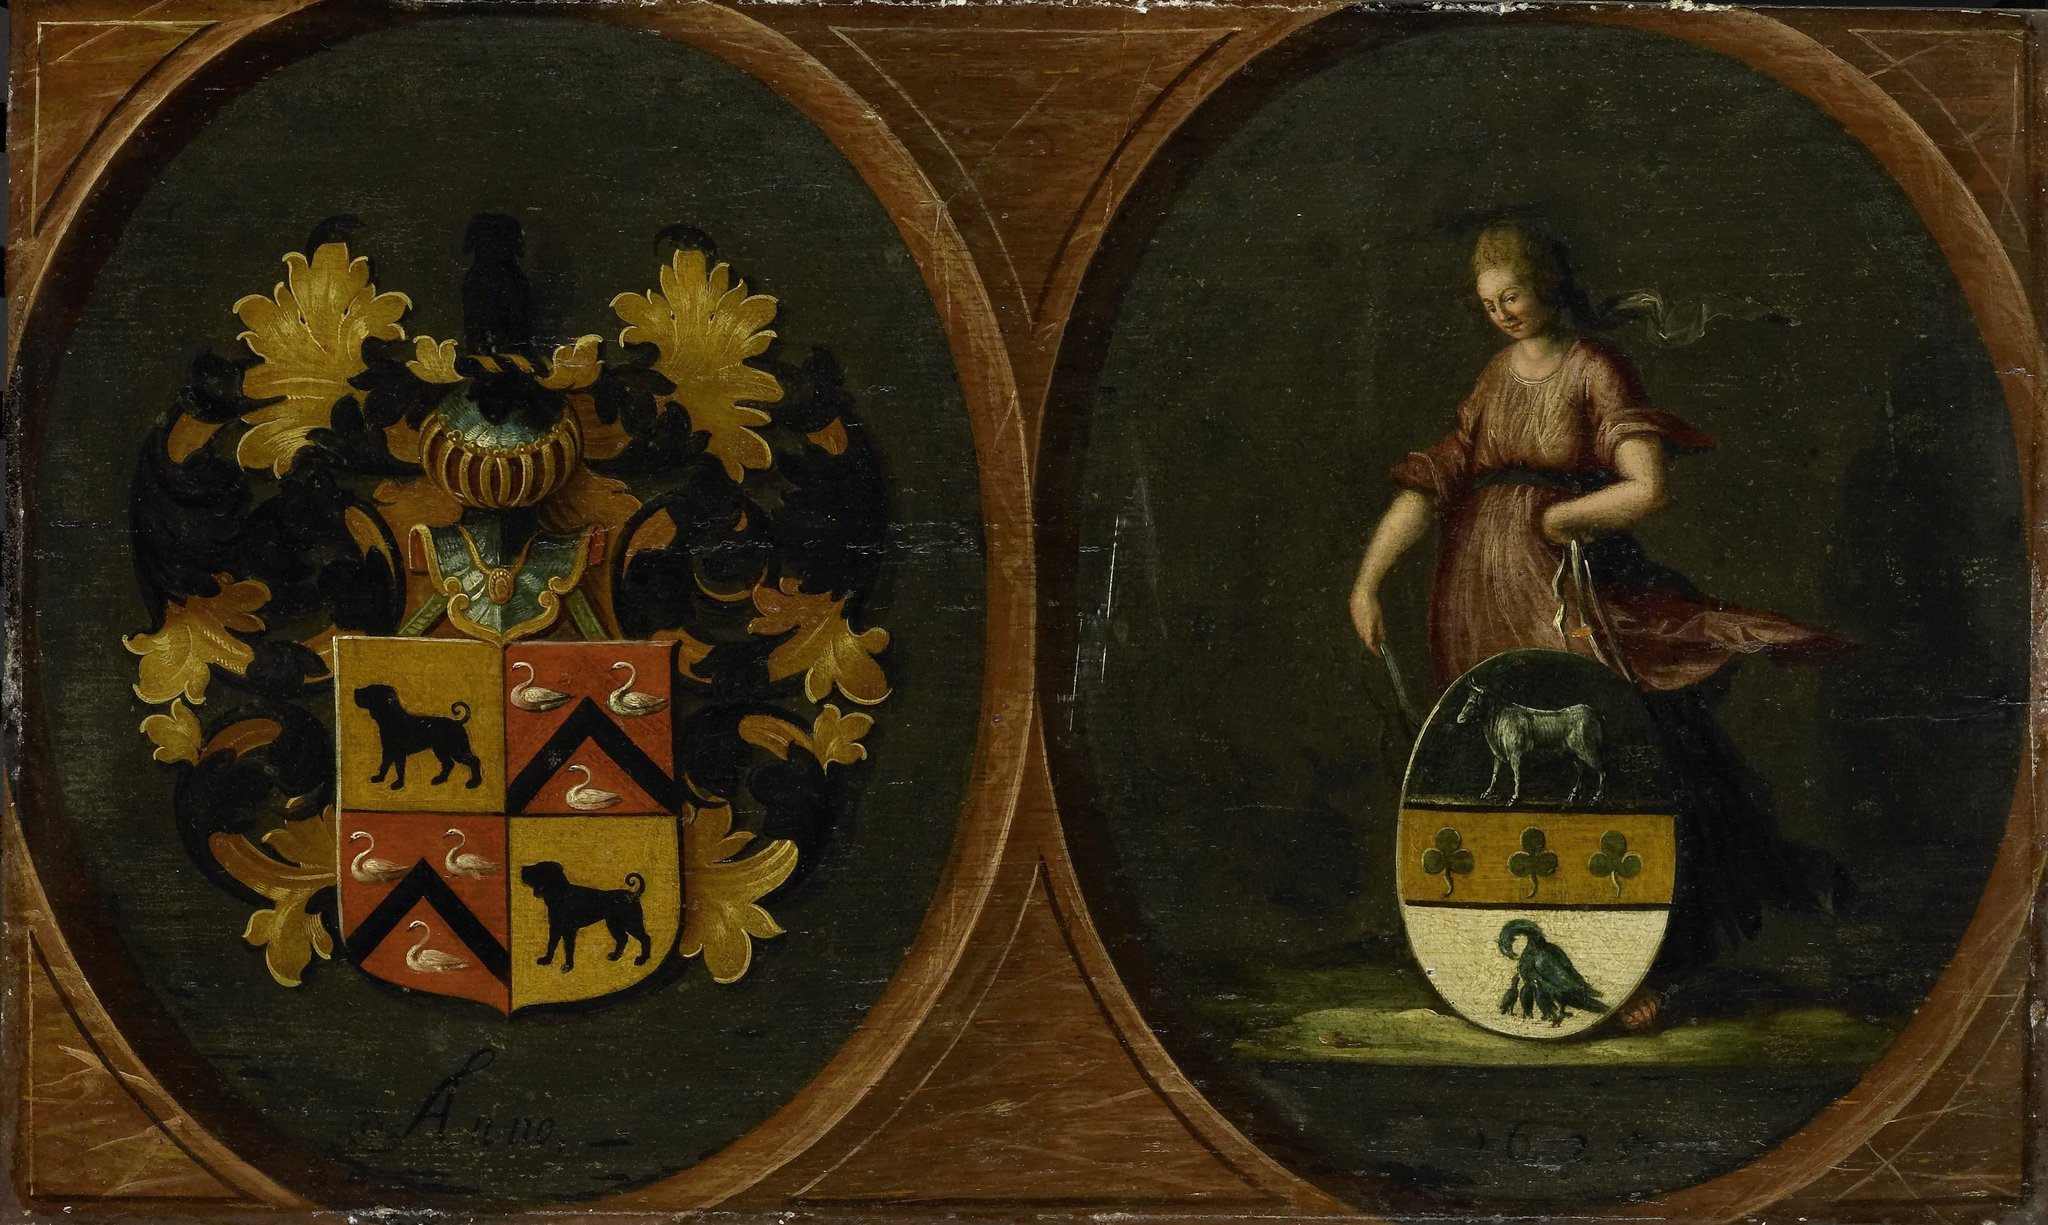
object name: wapenbord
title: Wapenbord met de wapens van het echtpaar Pieter Courten en Hortensia del Prado, 1625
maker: Anonymous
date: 1625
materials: oil, panel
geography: northern netherlands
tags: middelburg, pieter courten, armorial bearing, heraldry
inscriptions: date: ‘Anno. / 1625.’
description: Wapenbord met de wapens van het echtpaar Pieter Courten en Hortensia del Prado, 1625. Onderdeel van een reeks wapens behorend bij de schenking Jonkheer J. de Witte van Citters, Den Haag, 1876. Onderdeel van de collectie heraldische objecten.